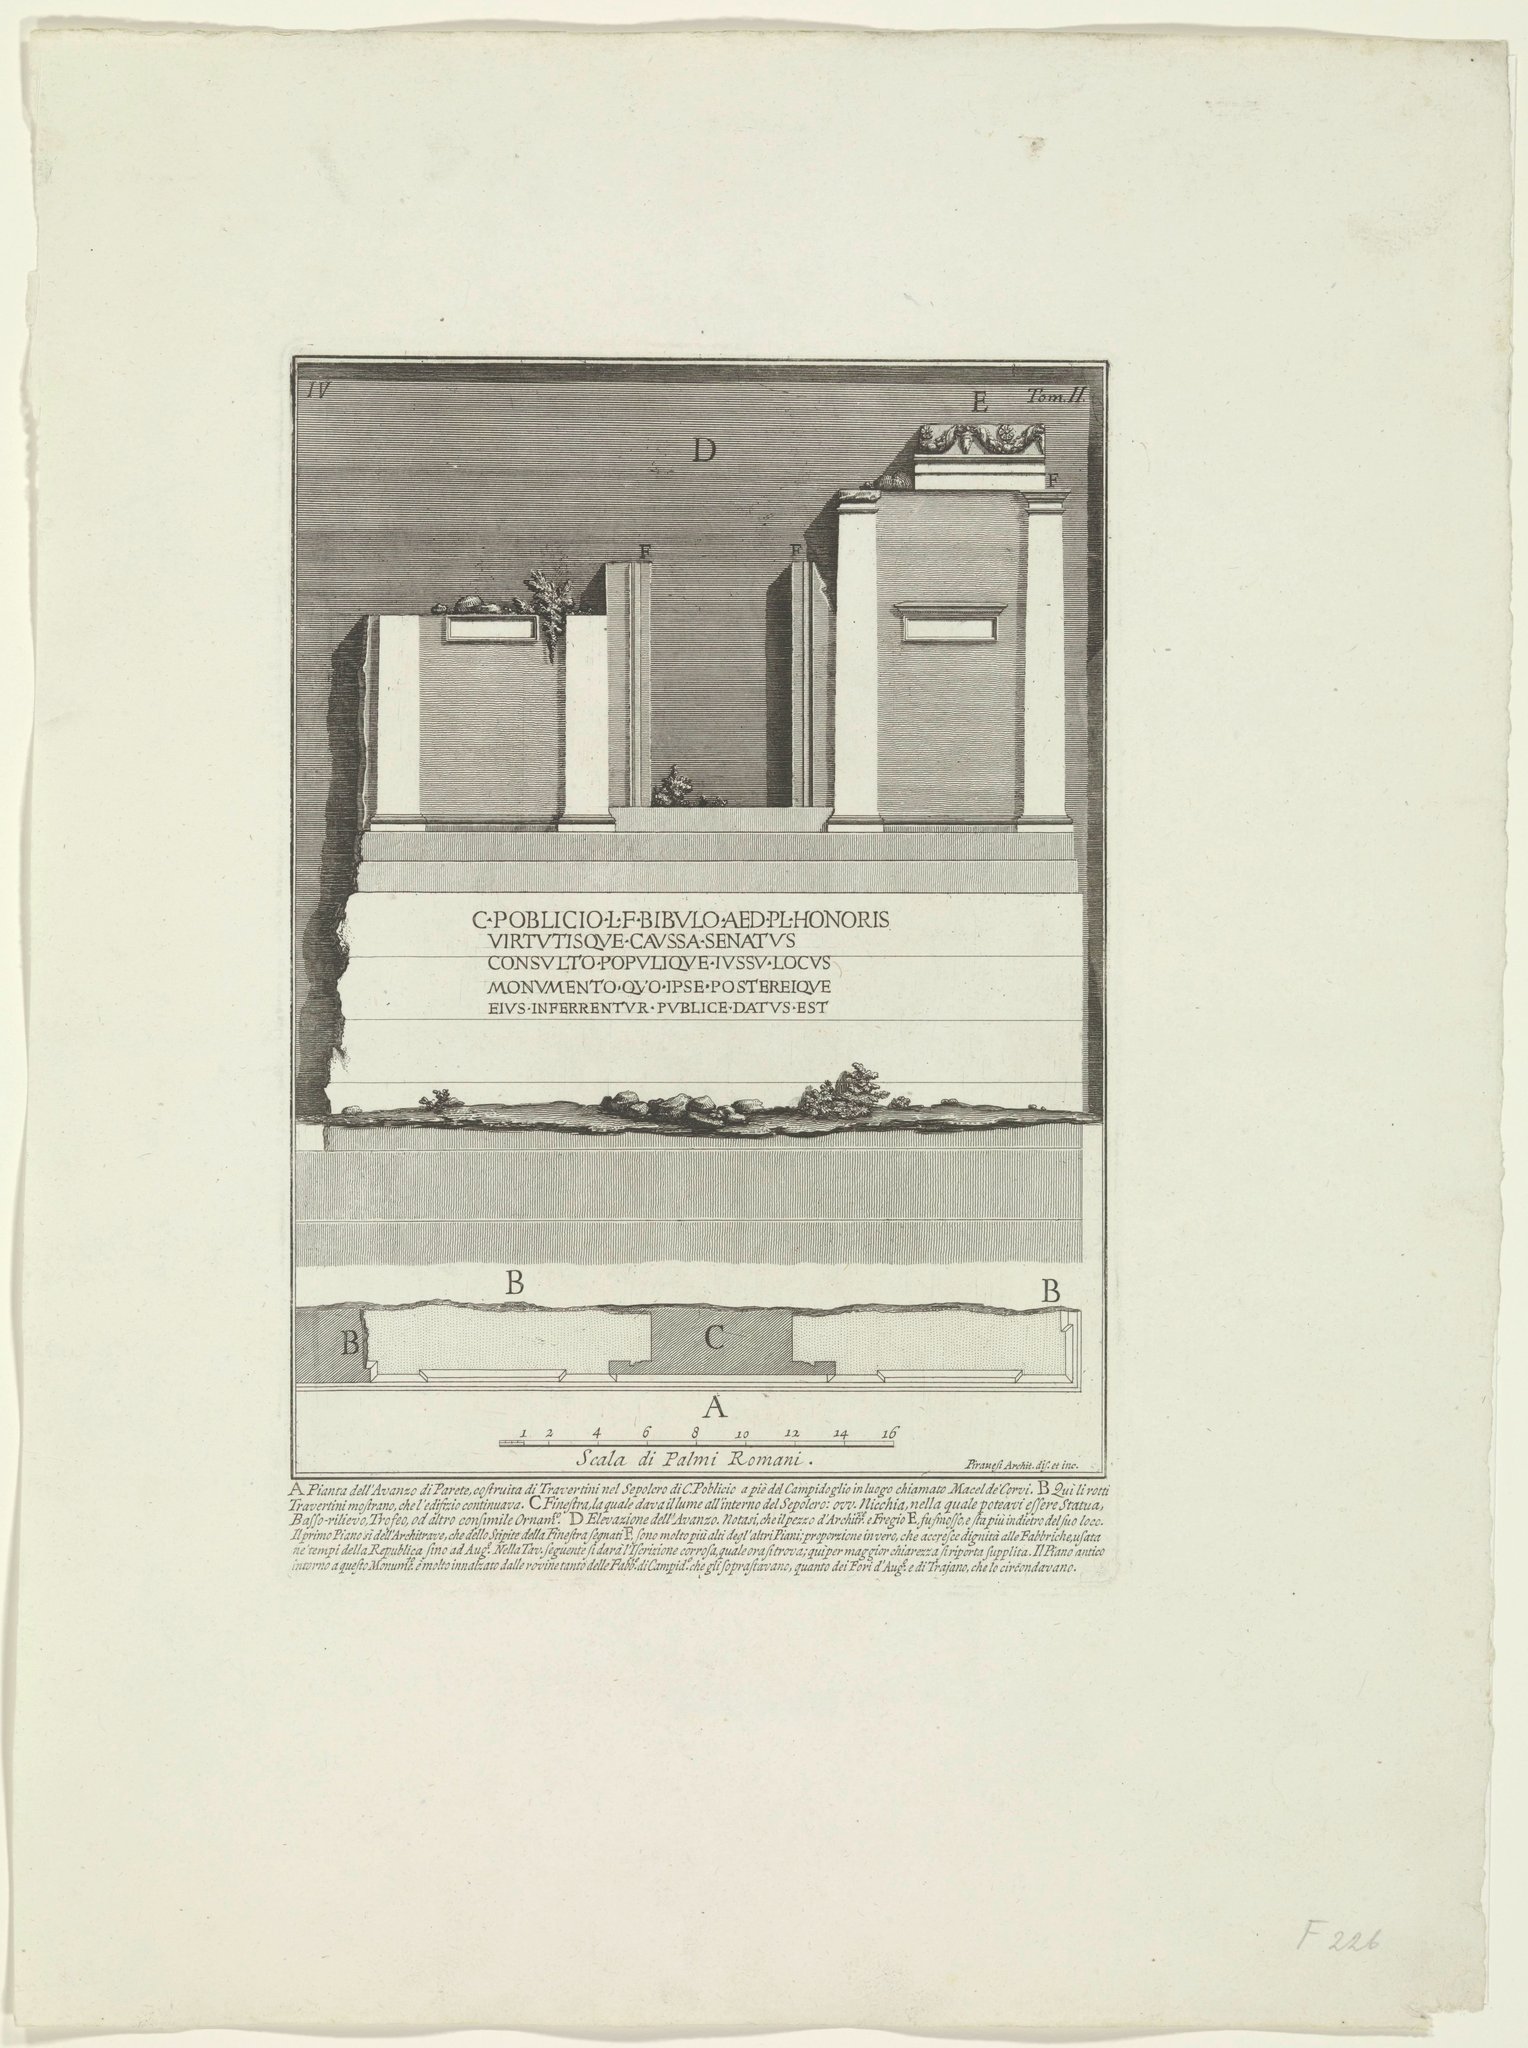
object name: print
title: Archeologische vondsten in en rond Rome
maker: giovanni battista piranesi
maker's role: designer, draughtsman, print maker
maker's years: 1720-1778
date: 1756-1757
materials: paper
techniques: etching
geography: rome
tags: ruin of a building ~ architecture, grave, tomb, plan ~ architecture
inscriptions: collector's mark: Lugt 2228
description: Deze prent maakt deel uit van de serie 'Le Antichità Romane'. Piranesi deed meer dan acht jaar voorstudie voor deze 250 platen tellende serie die in vier volumes werd uitgegeven. Hij produceerde de prenten tussen ca. 1756 en 1757. De serie bevat ook prenten door of naar andere prentmakers, onder wie Francesco Bianchini en Girolamo Rossi.